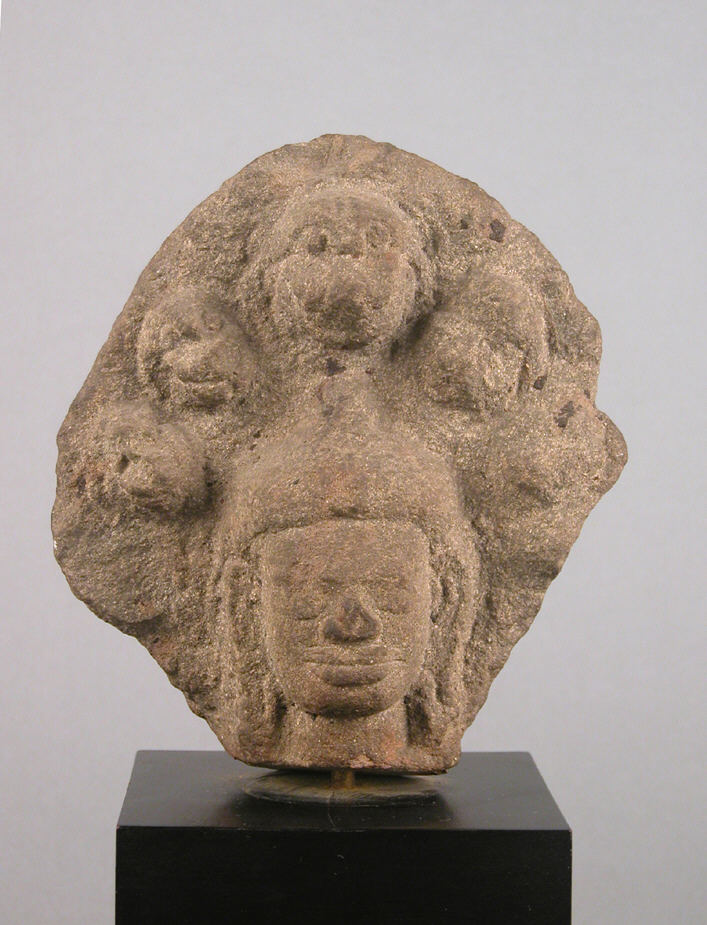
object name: head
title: Head of a Buddha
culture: cambodian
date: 900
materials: stone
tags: heads,buddhism,buddha